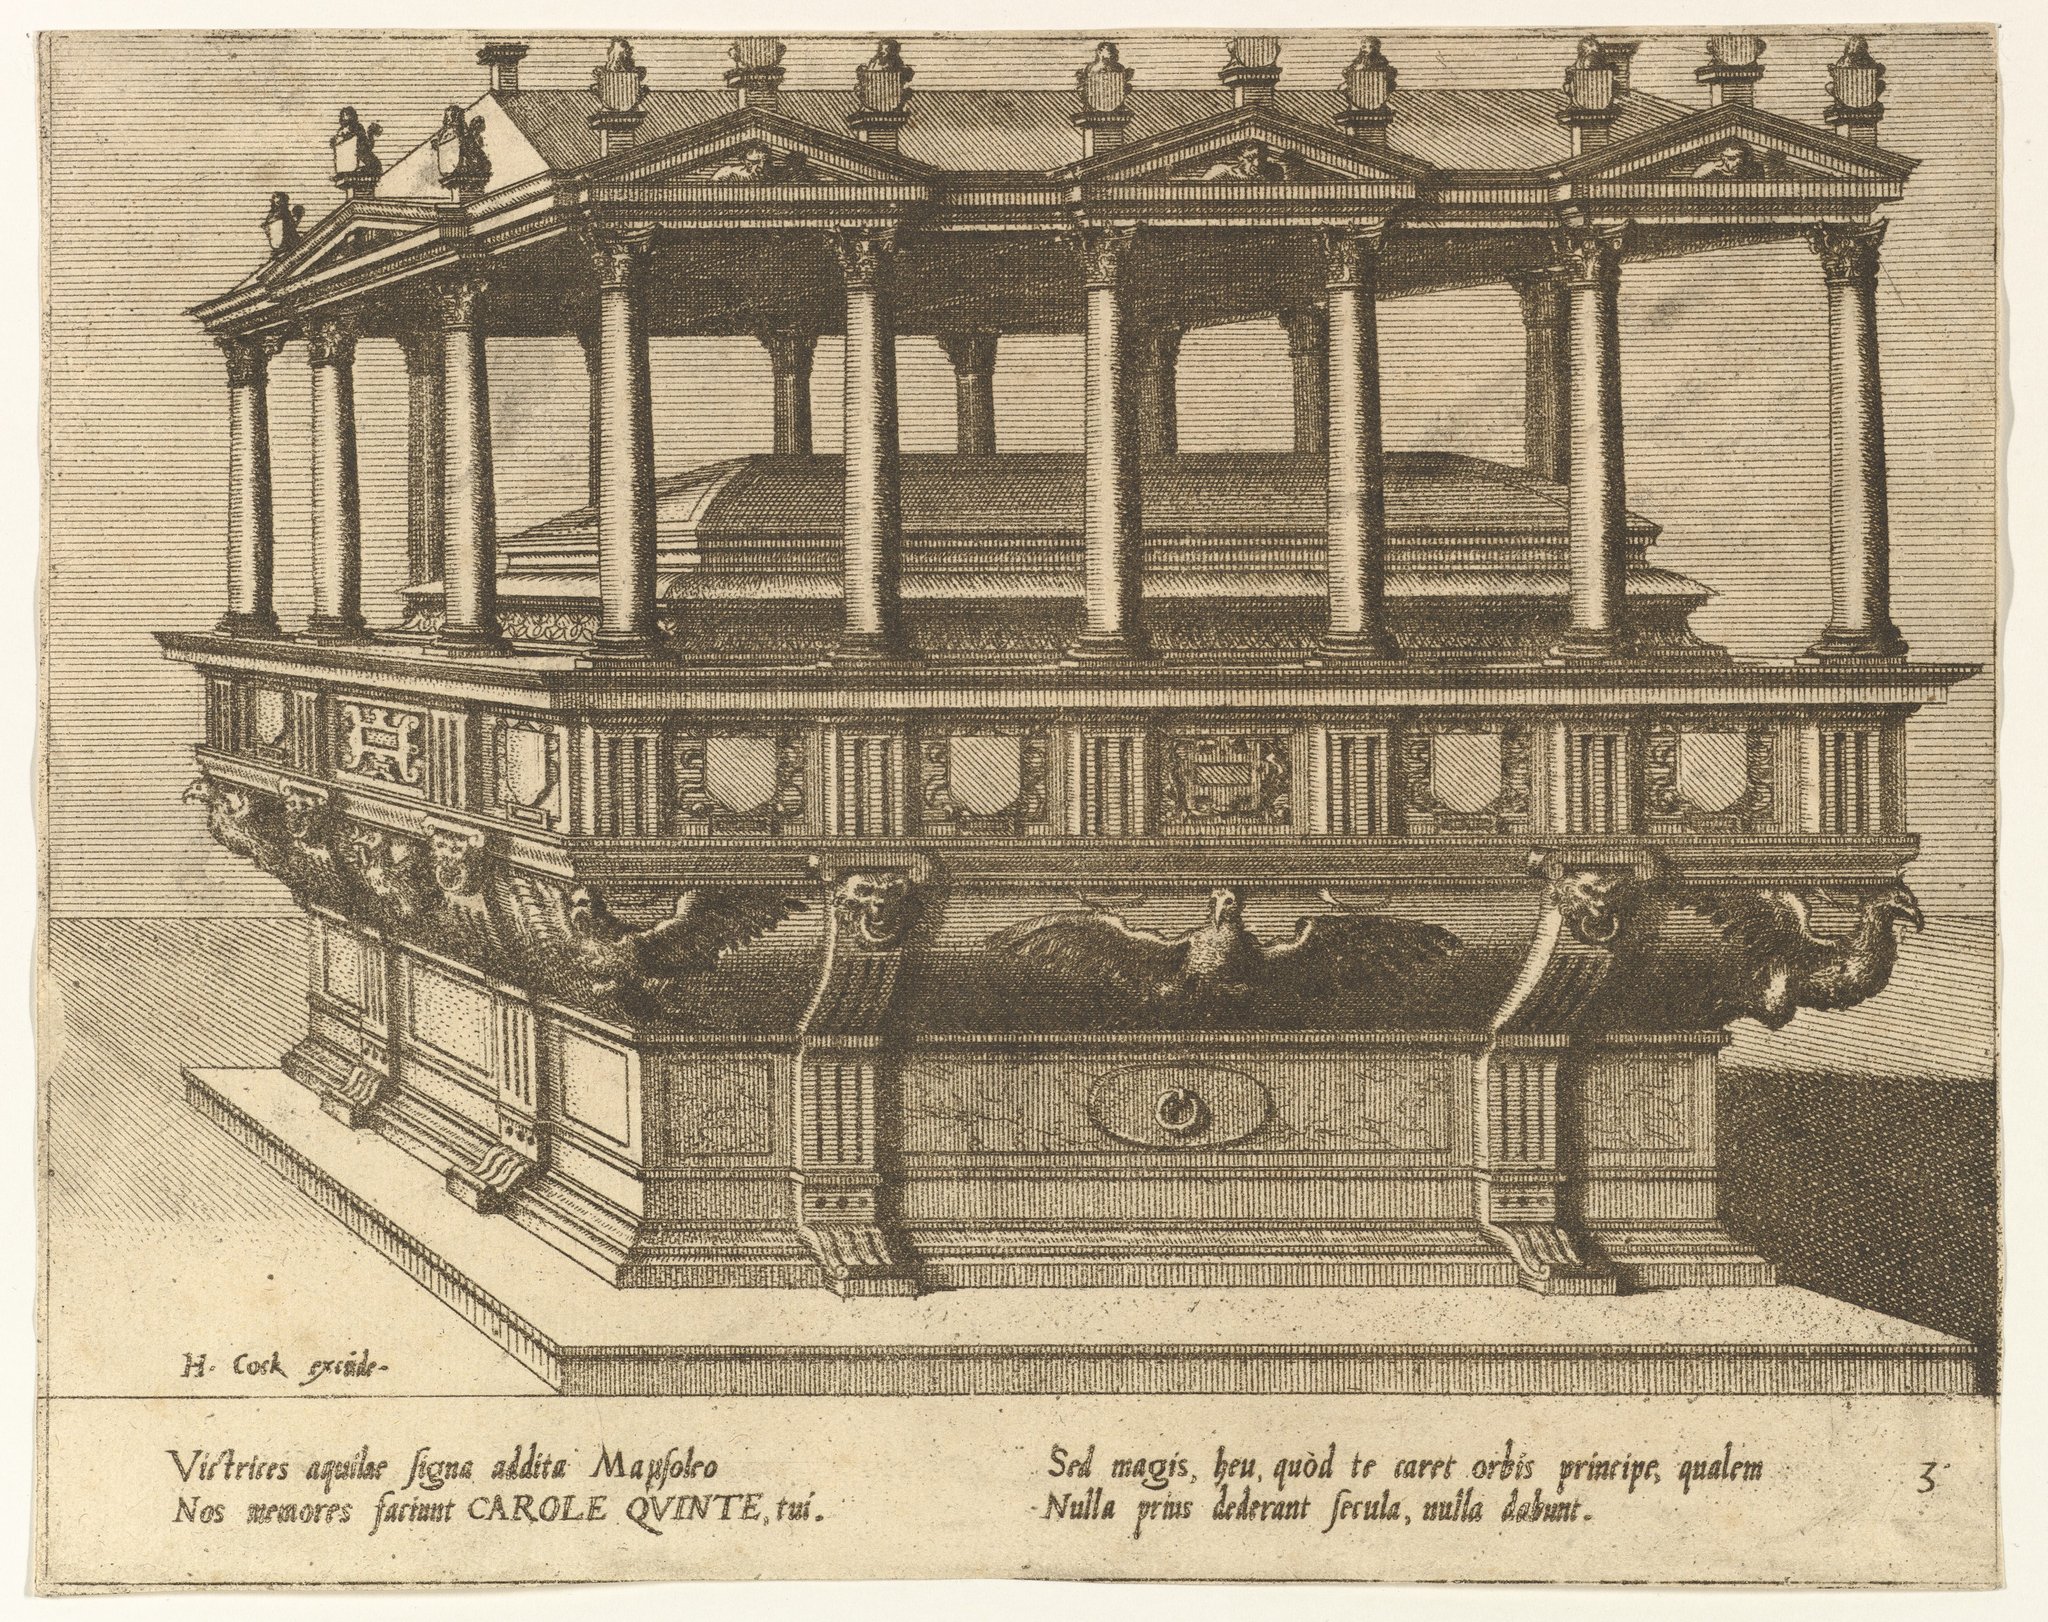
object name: collection ornament architecture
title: Cœnotaphiorum (3)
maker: hans vredeman de vries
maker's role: artist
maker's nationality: netherlandish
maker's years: 1527-1606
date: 1563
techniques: etching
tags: birds,tombs,coat of arms